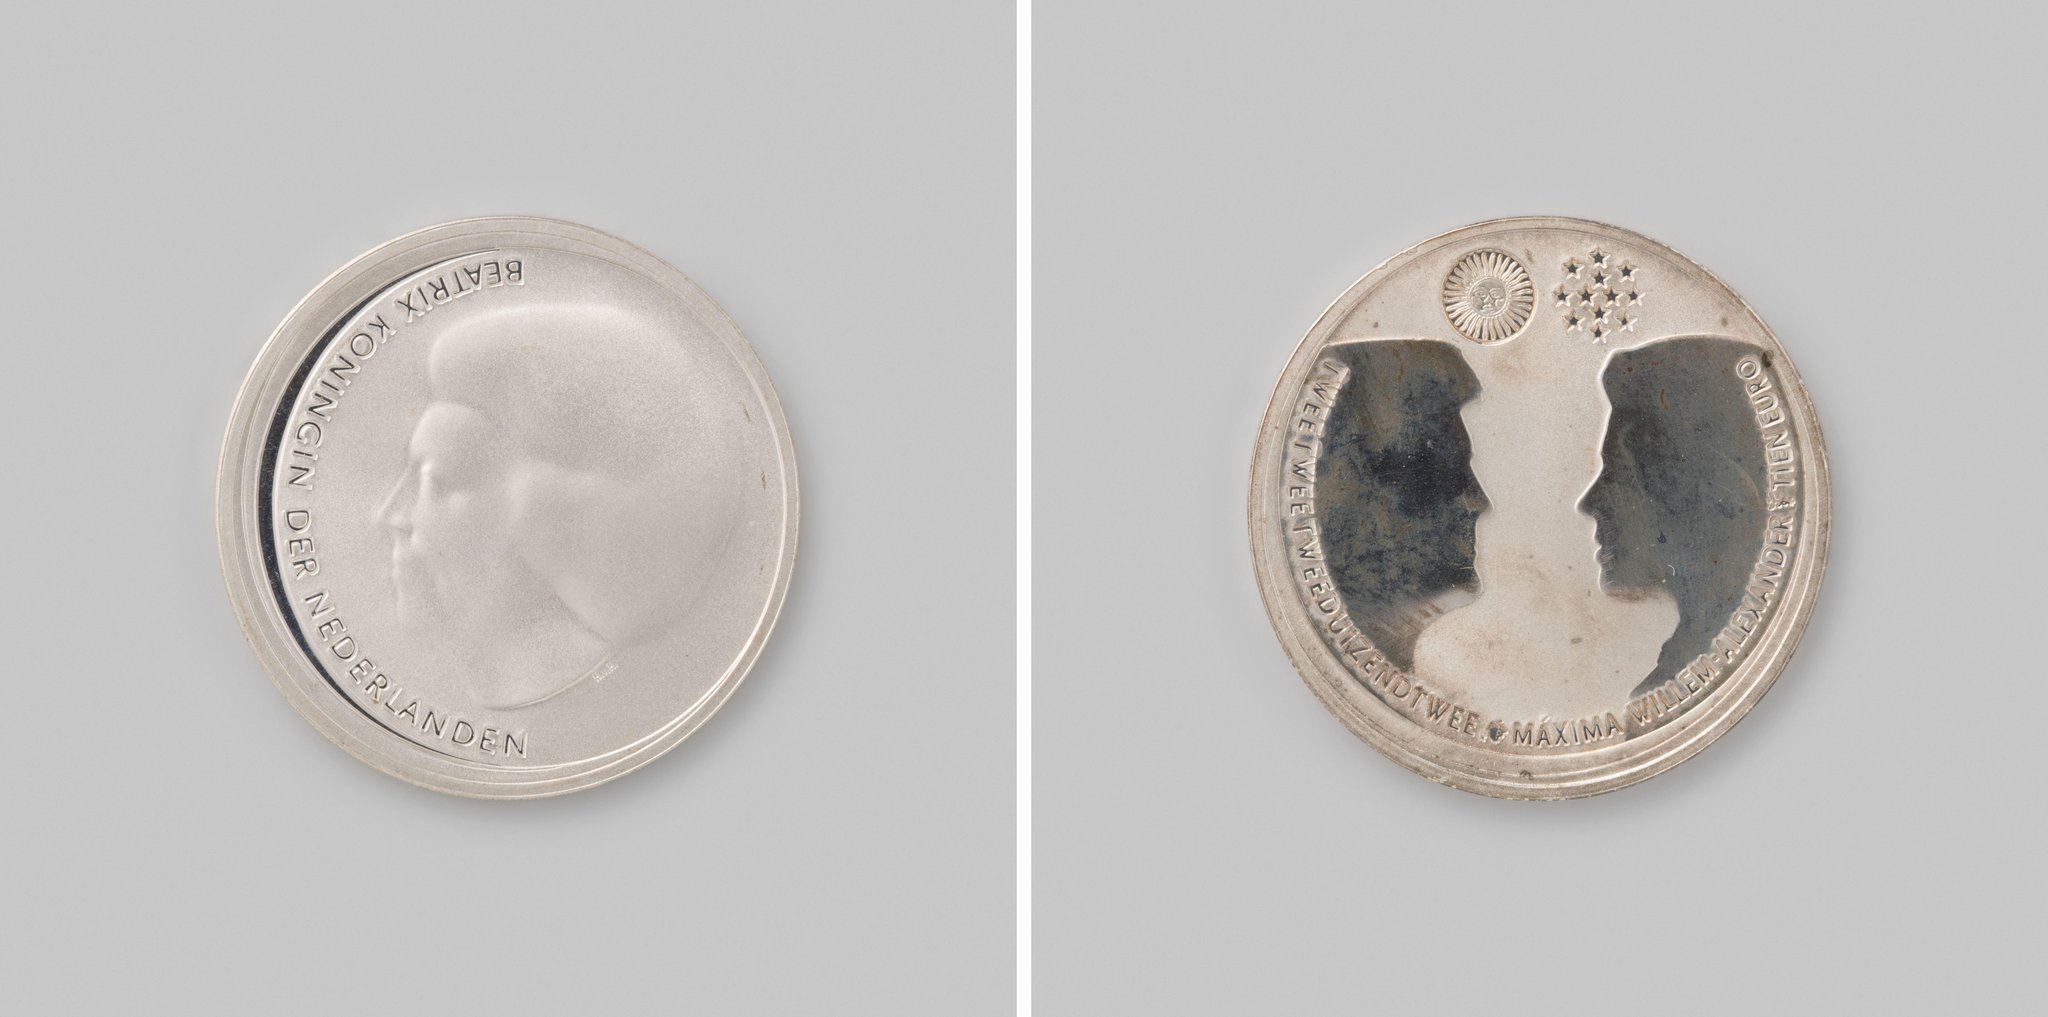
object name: coin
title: Zilveren tien euro verzamelaarsmunt over het huwelijk van Willem-Alexander en Máxima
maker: hans van houwelingen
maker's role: medailleur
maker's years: 1957-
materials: silver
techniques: striking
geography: utrecht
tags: utrecht, beatrix (koningin der nederlanden), amsterdam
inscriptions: circumscription: ‘GOD * ZIJ * MET * ONS *’, inscription: ‘BEATRIX KONINGIN DER NEDERLANDEN’, inscription: ‘TWEE TWEE TWEEDUIZEND TWEE * MÁXIMA WILLEM-ALEXANDER * TIEN EURO’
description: Zilveren huwelijksmunt ter waarde van 10 Euro, ter ere van het huwelijk van Willem-Alexander en Máxima op 2 februari 2002. Voorzijde: portret van koningin Beatrix met omschrift. Keerzijde: de portretten van het echtpaar met de gezichten naar elkaar toe met omschrift. Daarboven twee merken: twaalf sterren en een zon. Geleverd samen met de gouden huwelijksmunt (21-A).